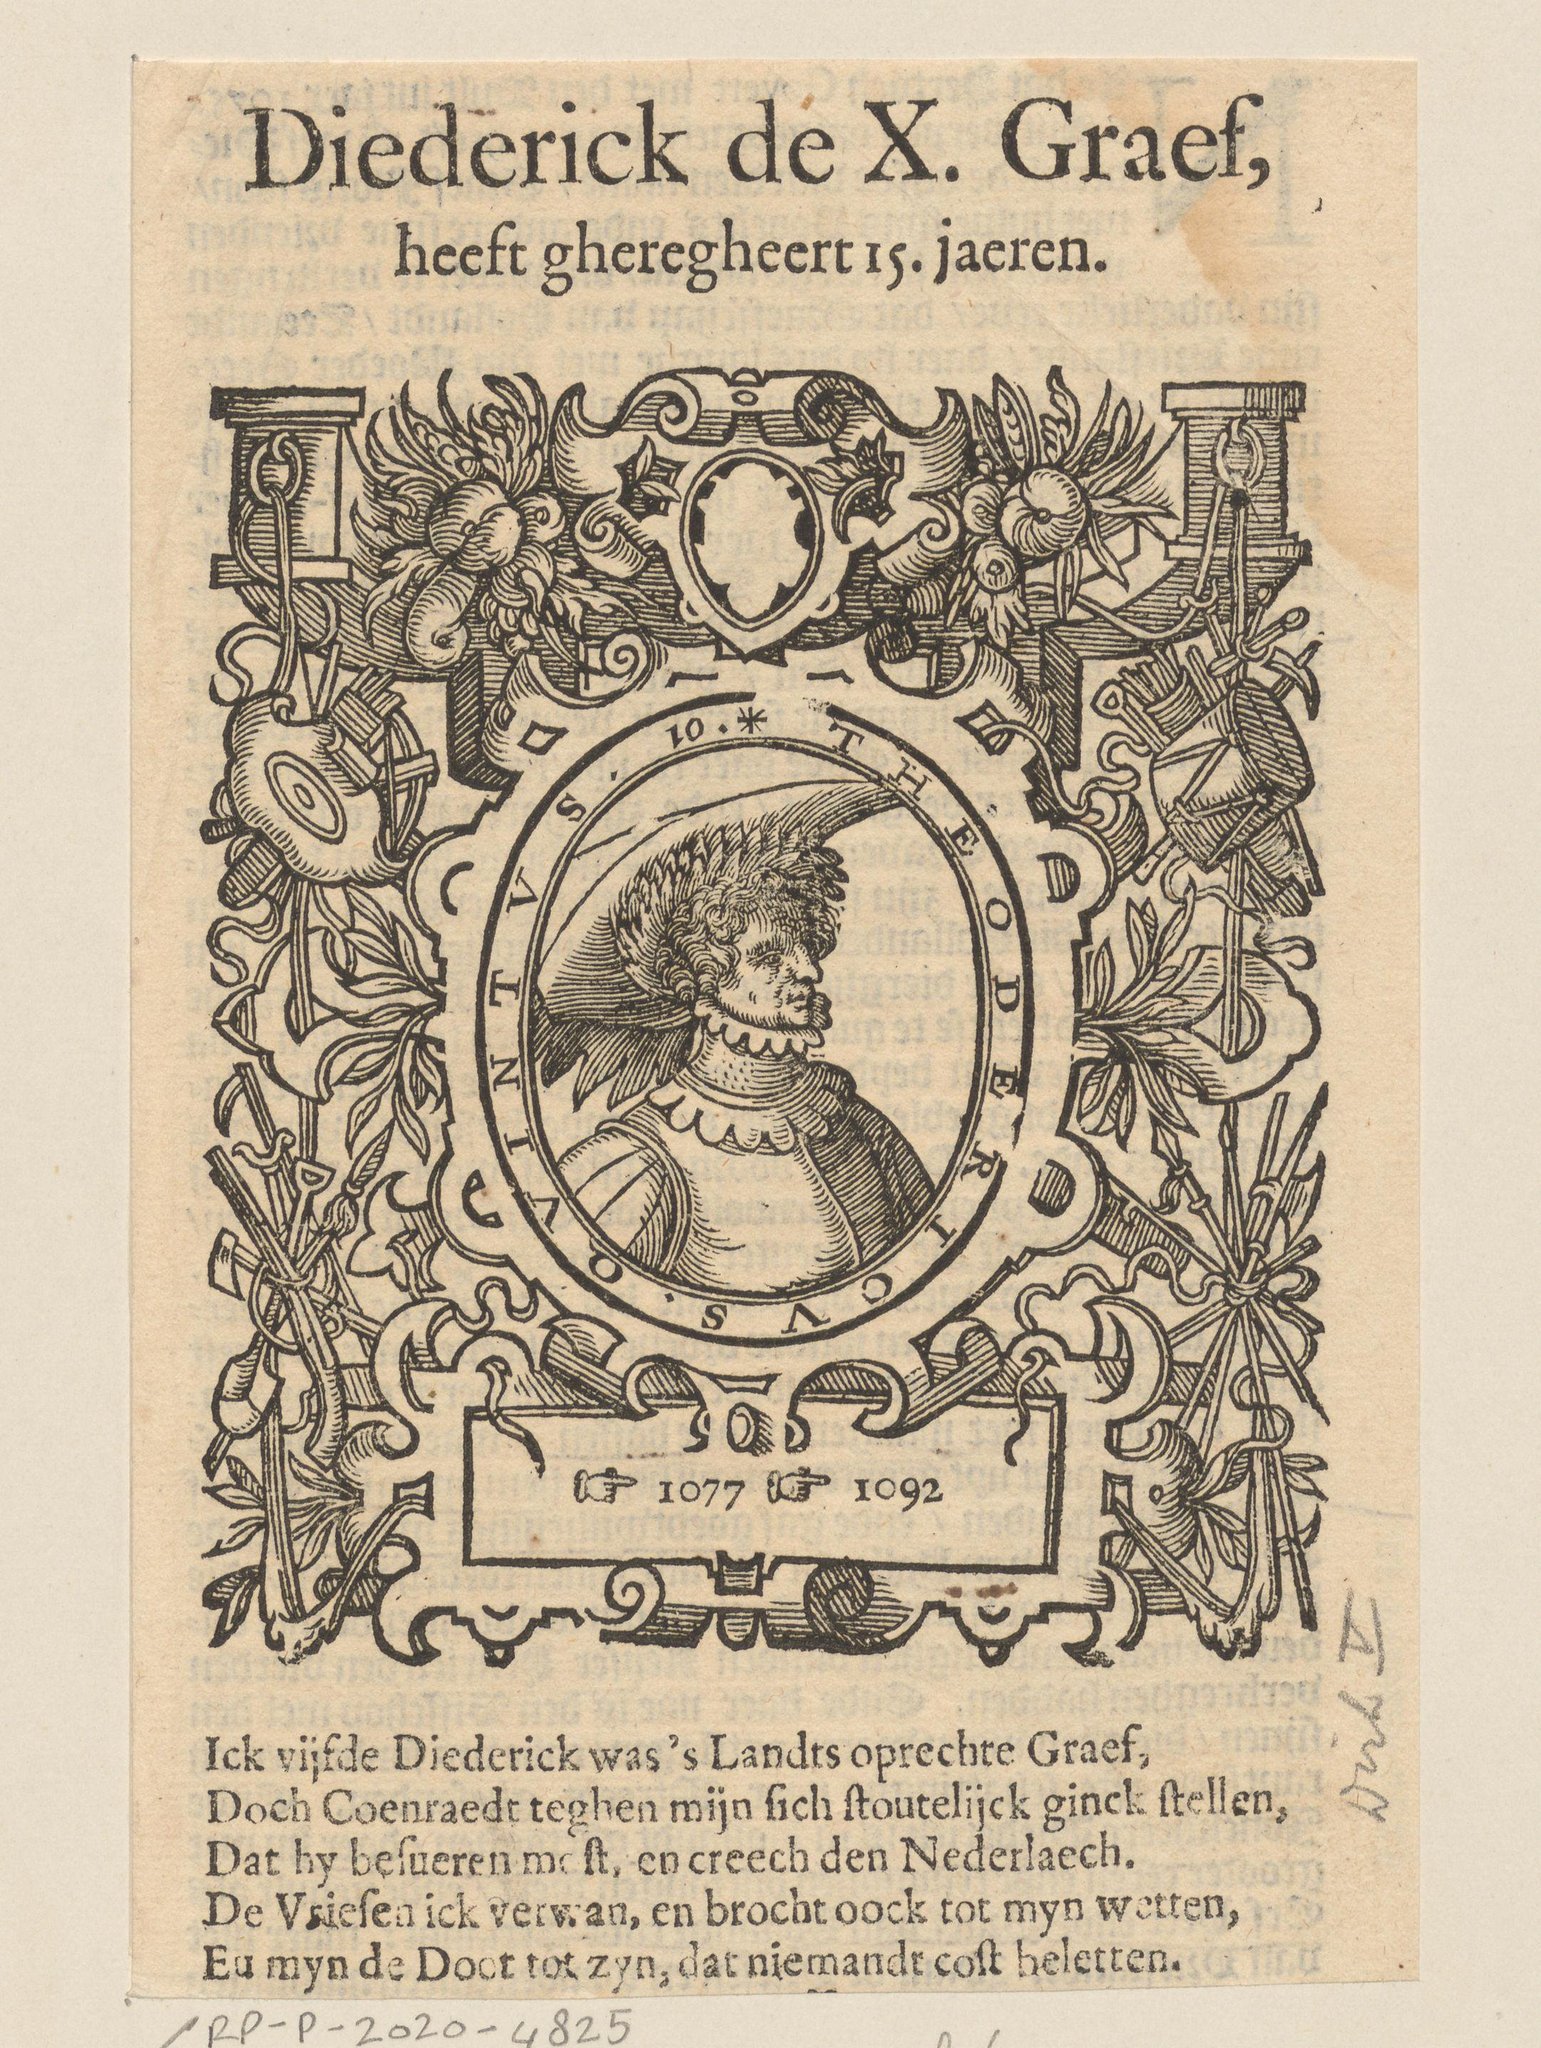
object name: book illustration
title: Portret van Dirk V, graaf van Holland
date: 1636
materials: paper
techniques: letterpress printing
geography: amsterdam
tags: earl, helmet, historical persons, ruler, sovereign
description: Prent uit: Scriverius, Petrus. Beschrivinge van out Batavien met de antiquiteyten vandien (...). Amsterdam: Jan Evertsz Cloppenburgh, 1636, p. 117.